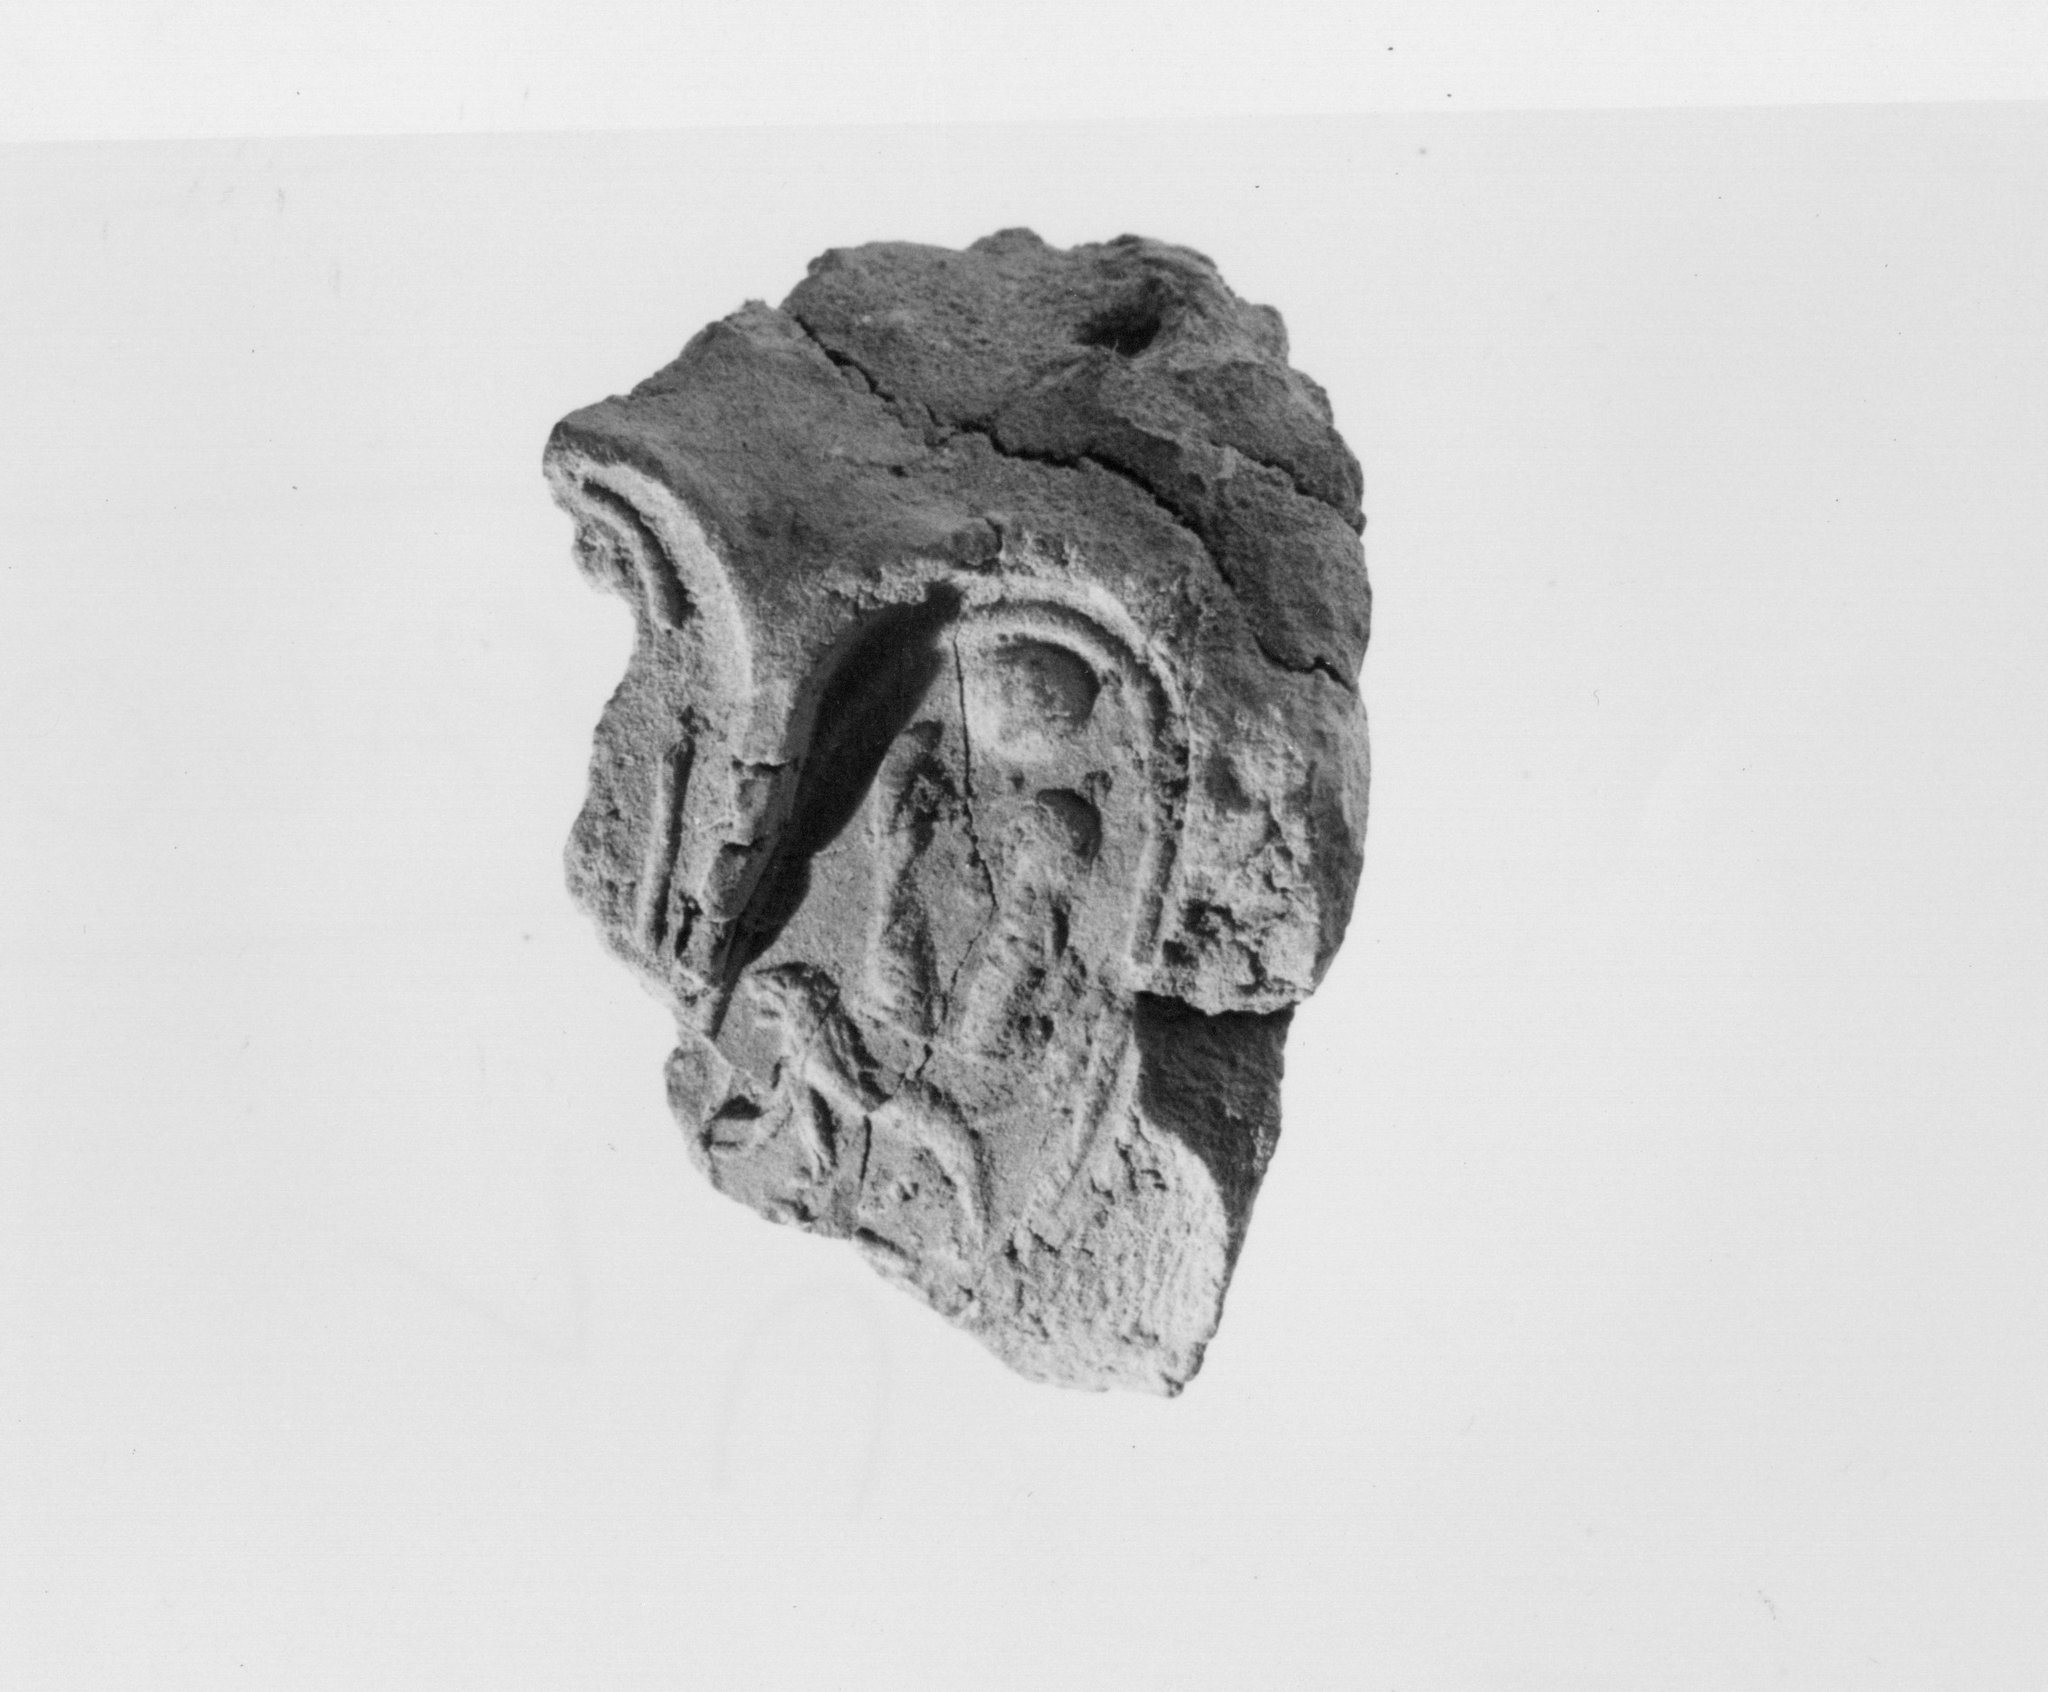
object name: sealing, nebmaatre, amenhotep iii, lion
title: Document Sealing With the Throne Name of Amenhotep III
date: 1390-1352 BCE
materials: mud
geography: egypt